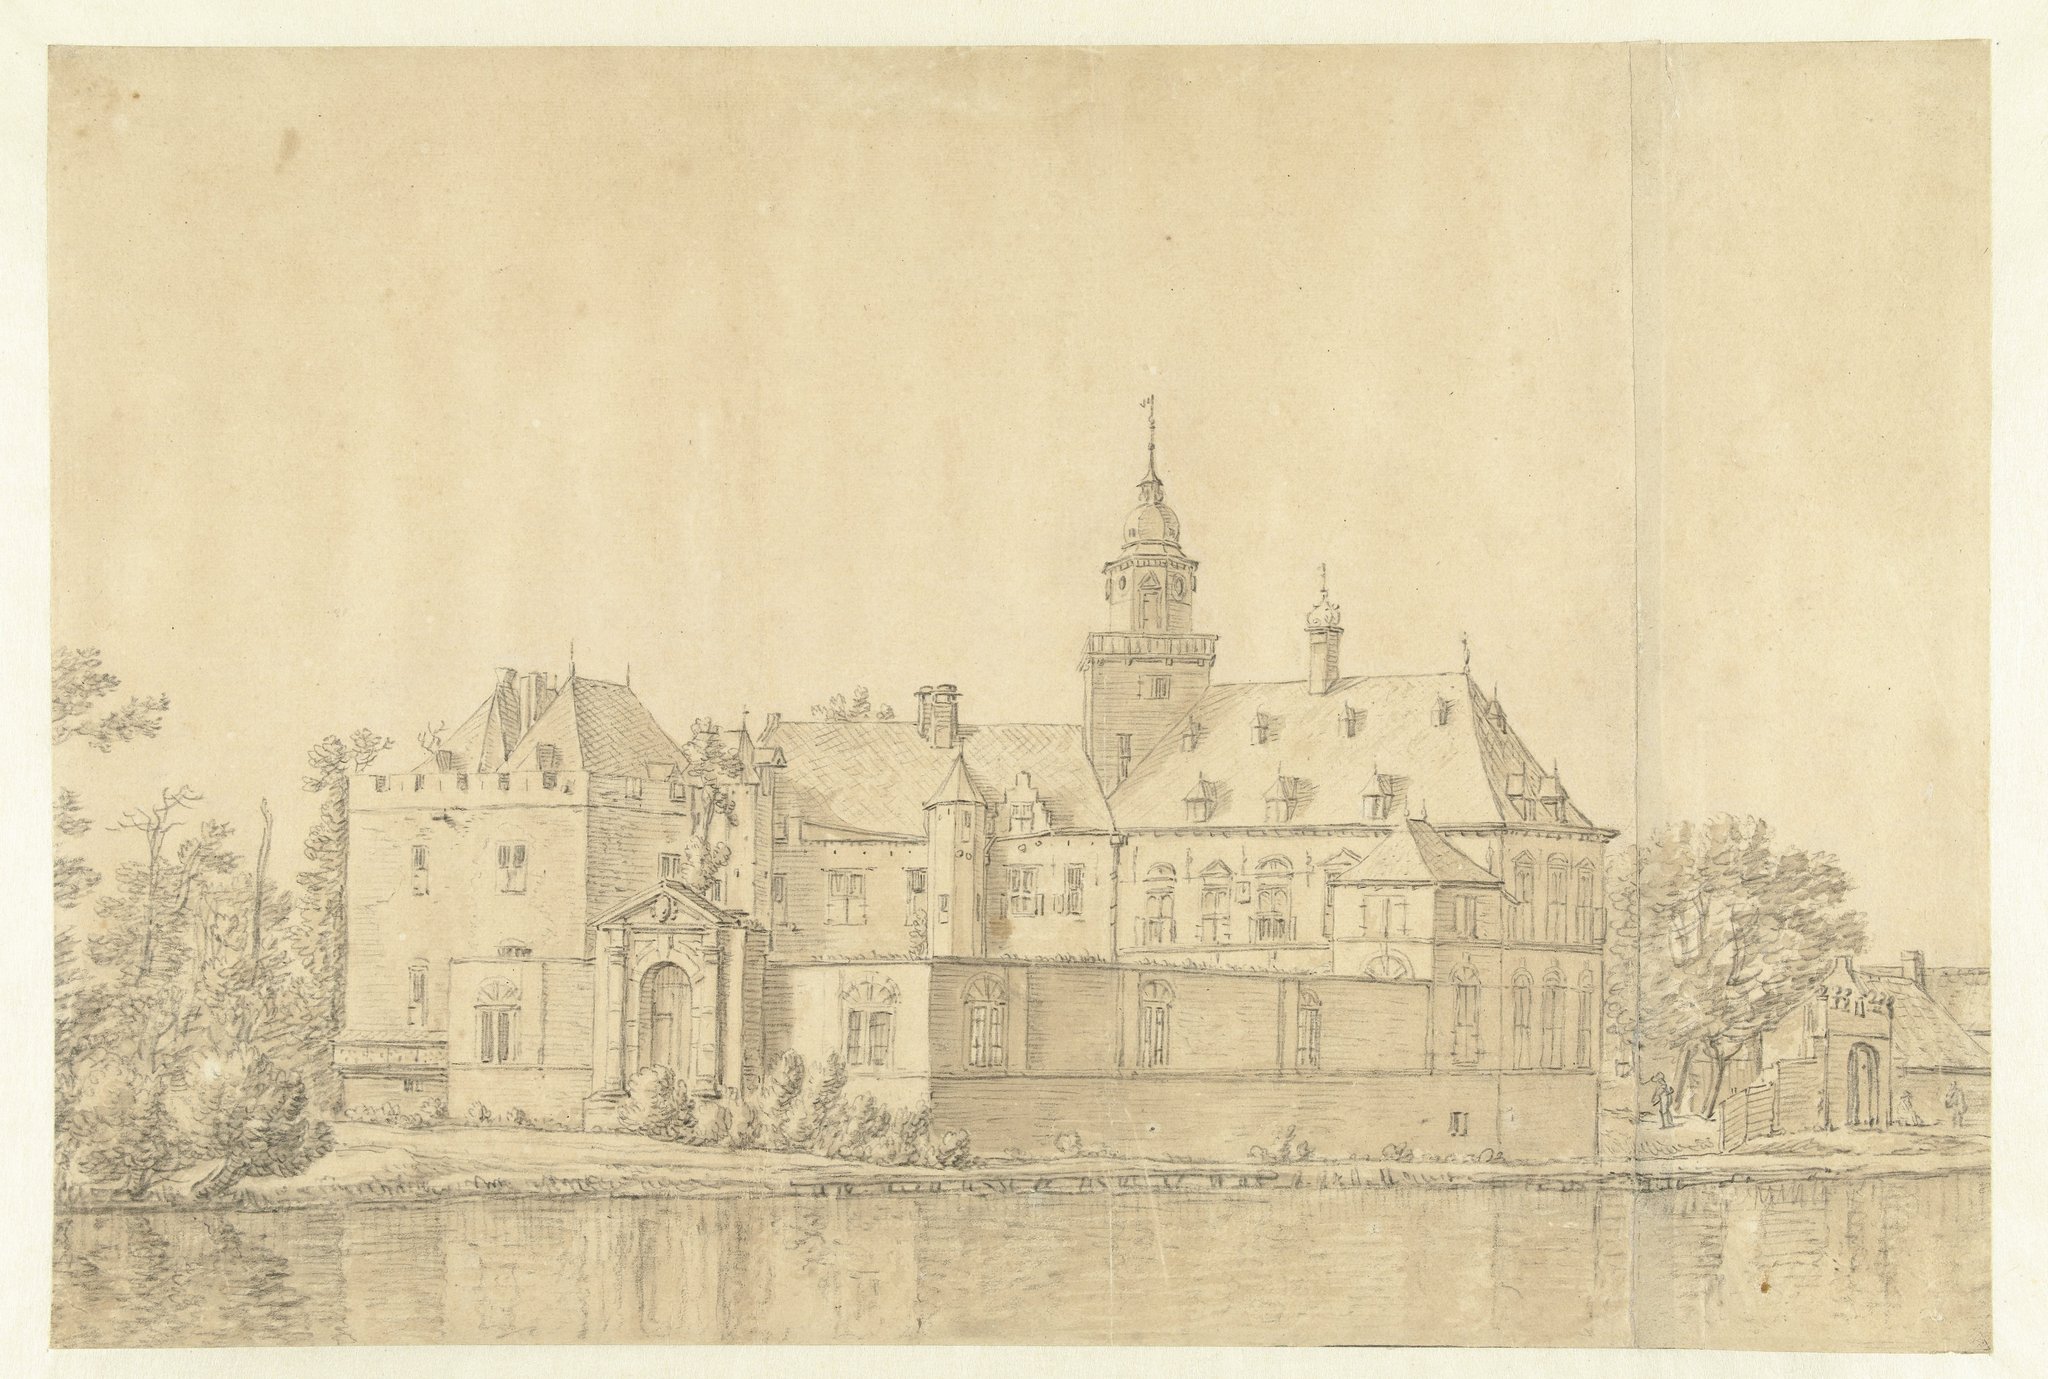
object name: drawing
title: Kasteel Nijenrode bij Breukelen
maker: herman saftleven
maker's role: draughtsman, painter, print maker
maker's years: 1609-1685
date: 1619-1685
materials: chalk, paper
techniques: brush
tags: castle